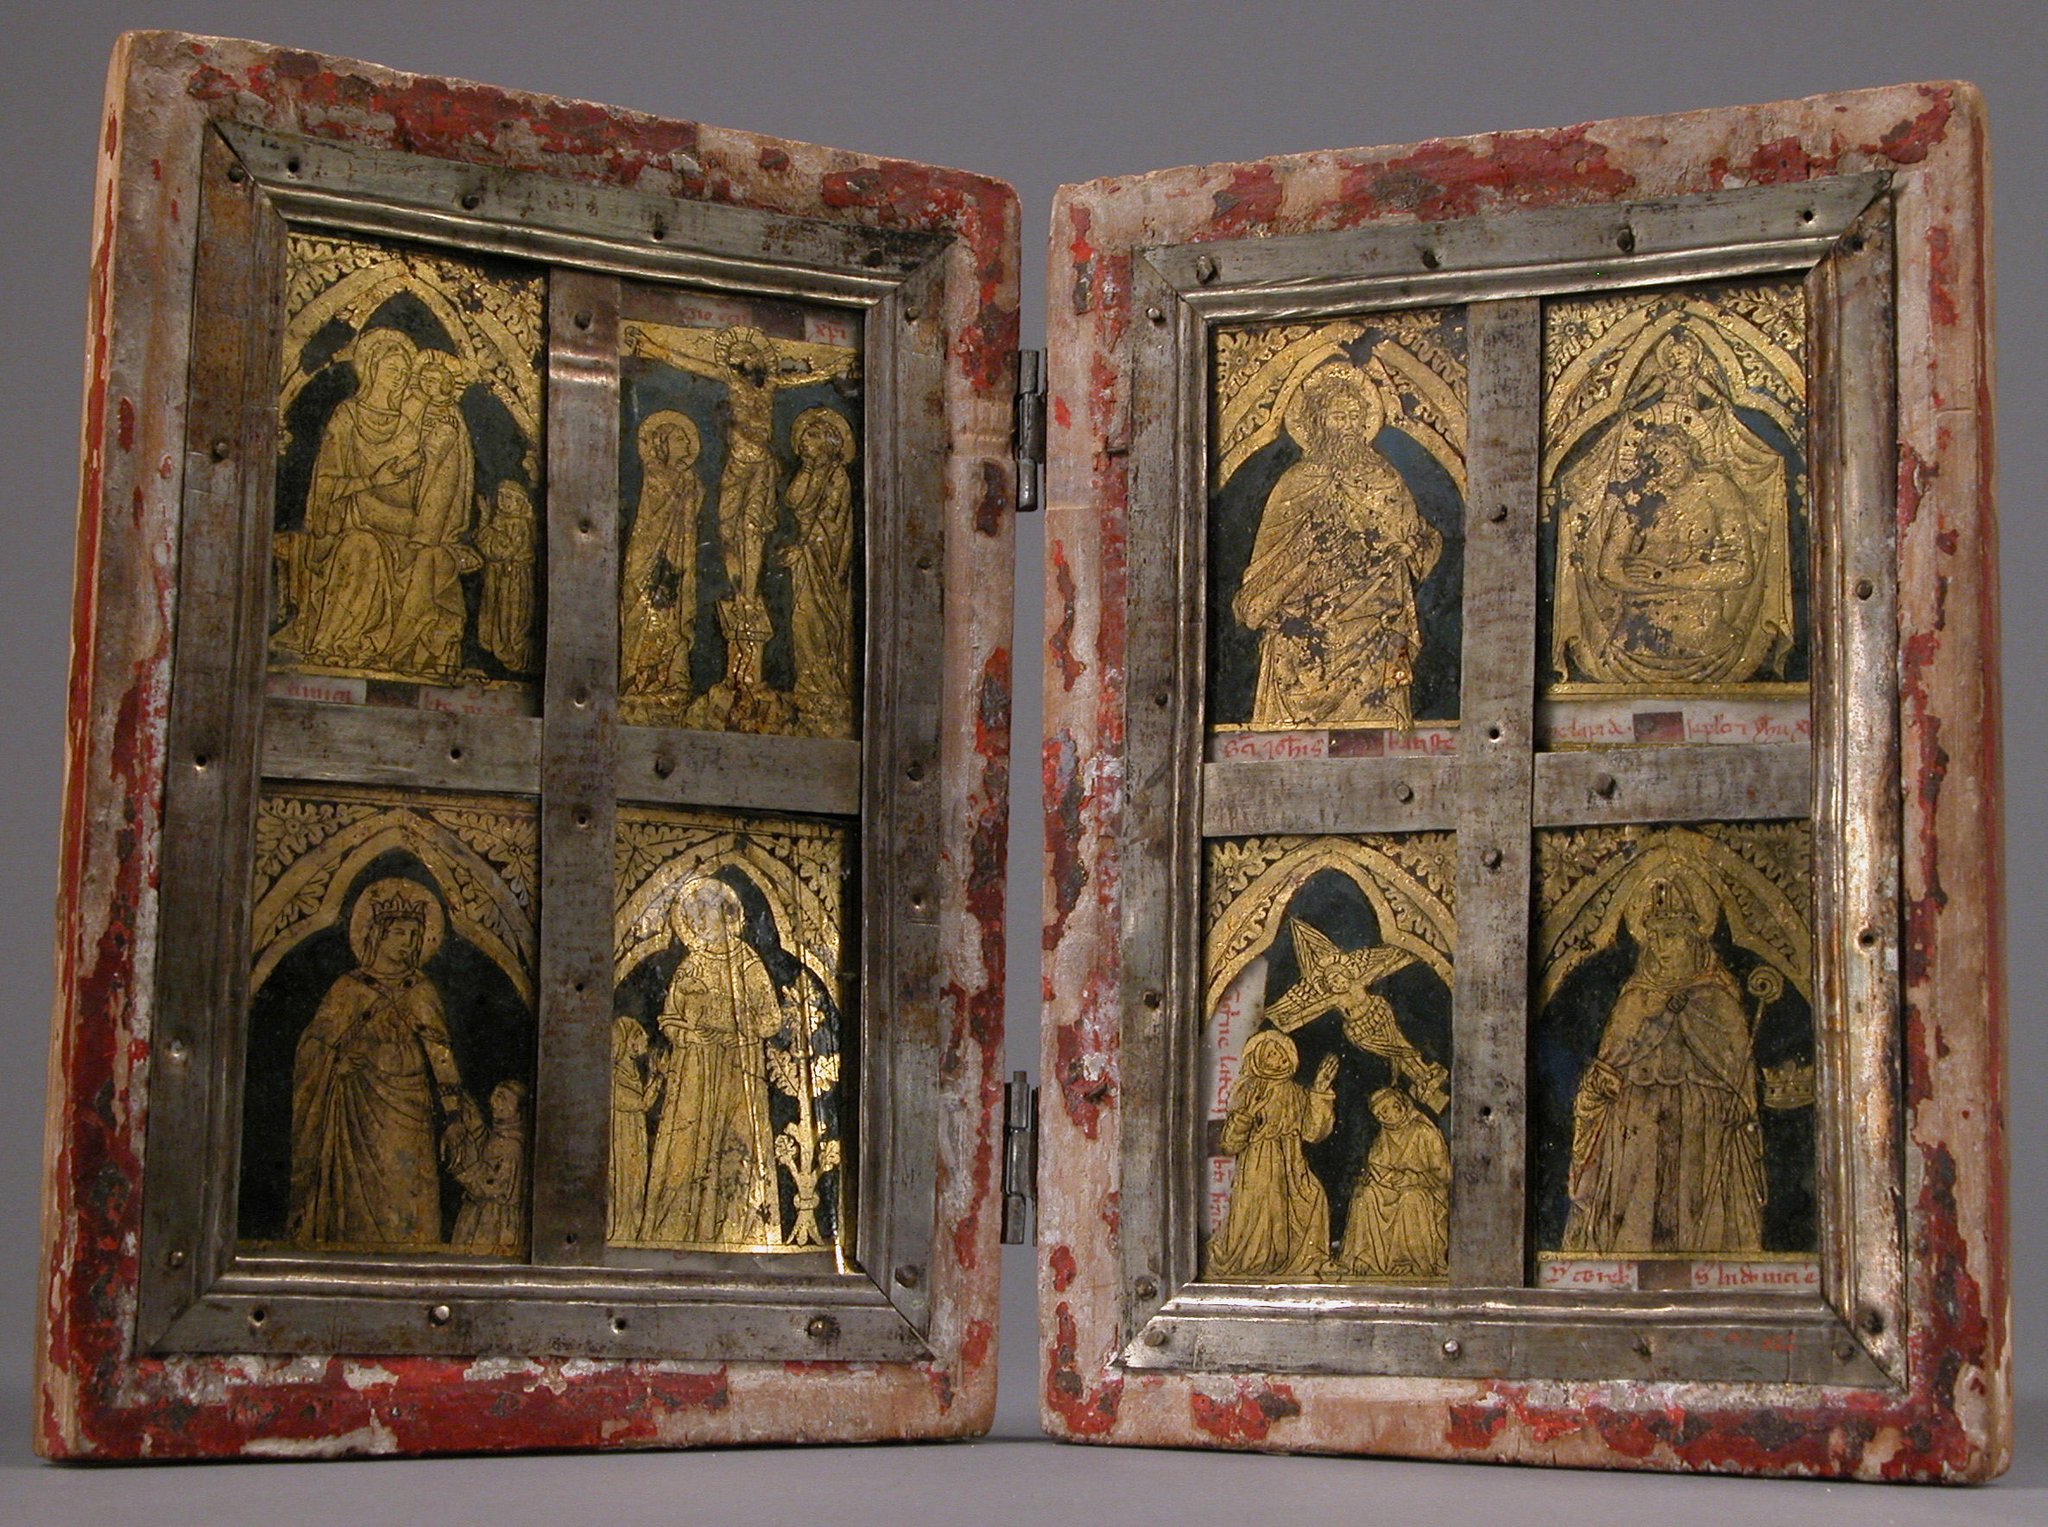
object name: reliquary diptych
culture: central italian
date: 1367-1400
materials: metal, wood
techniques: polychromy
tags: christ,madonna and child,crucifixion,saints